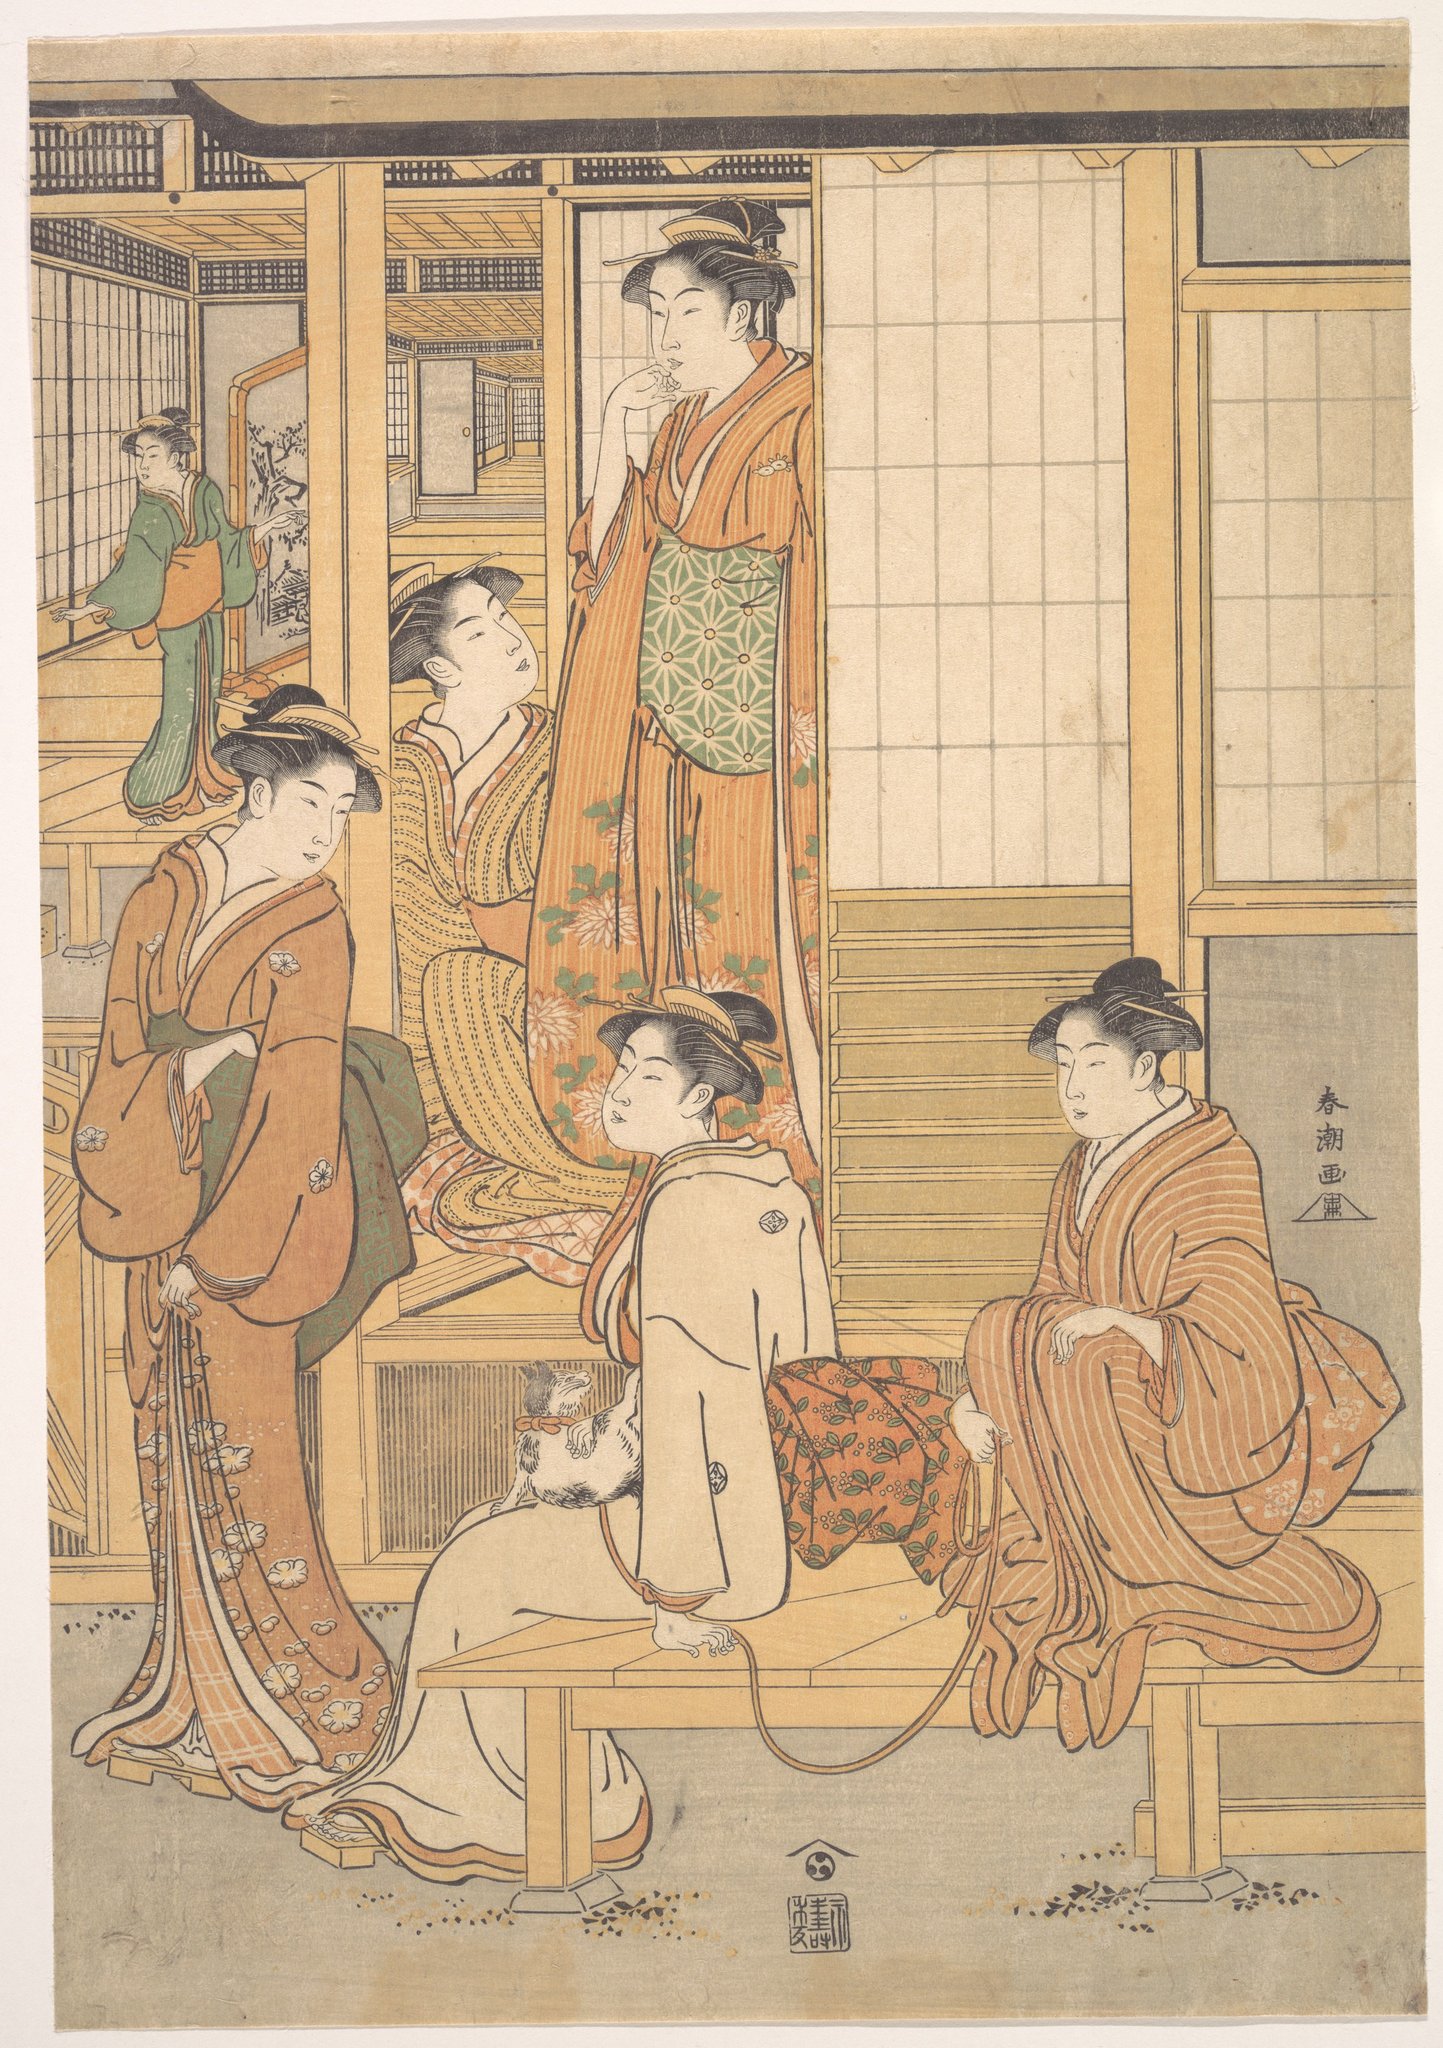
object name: woodblock print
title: Group of Young Women on the Veranda of a Tea House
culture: japanese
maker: katsukawa shunchō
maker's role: artist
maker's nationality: japanese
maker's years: 1775-1795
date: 1780-1795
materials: ink, paper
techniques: woodblock print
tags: women,cats,tea houses